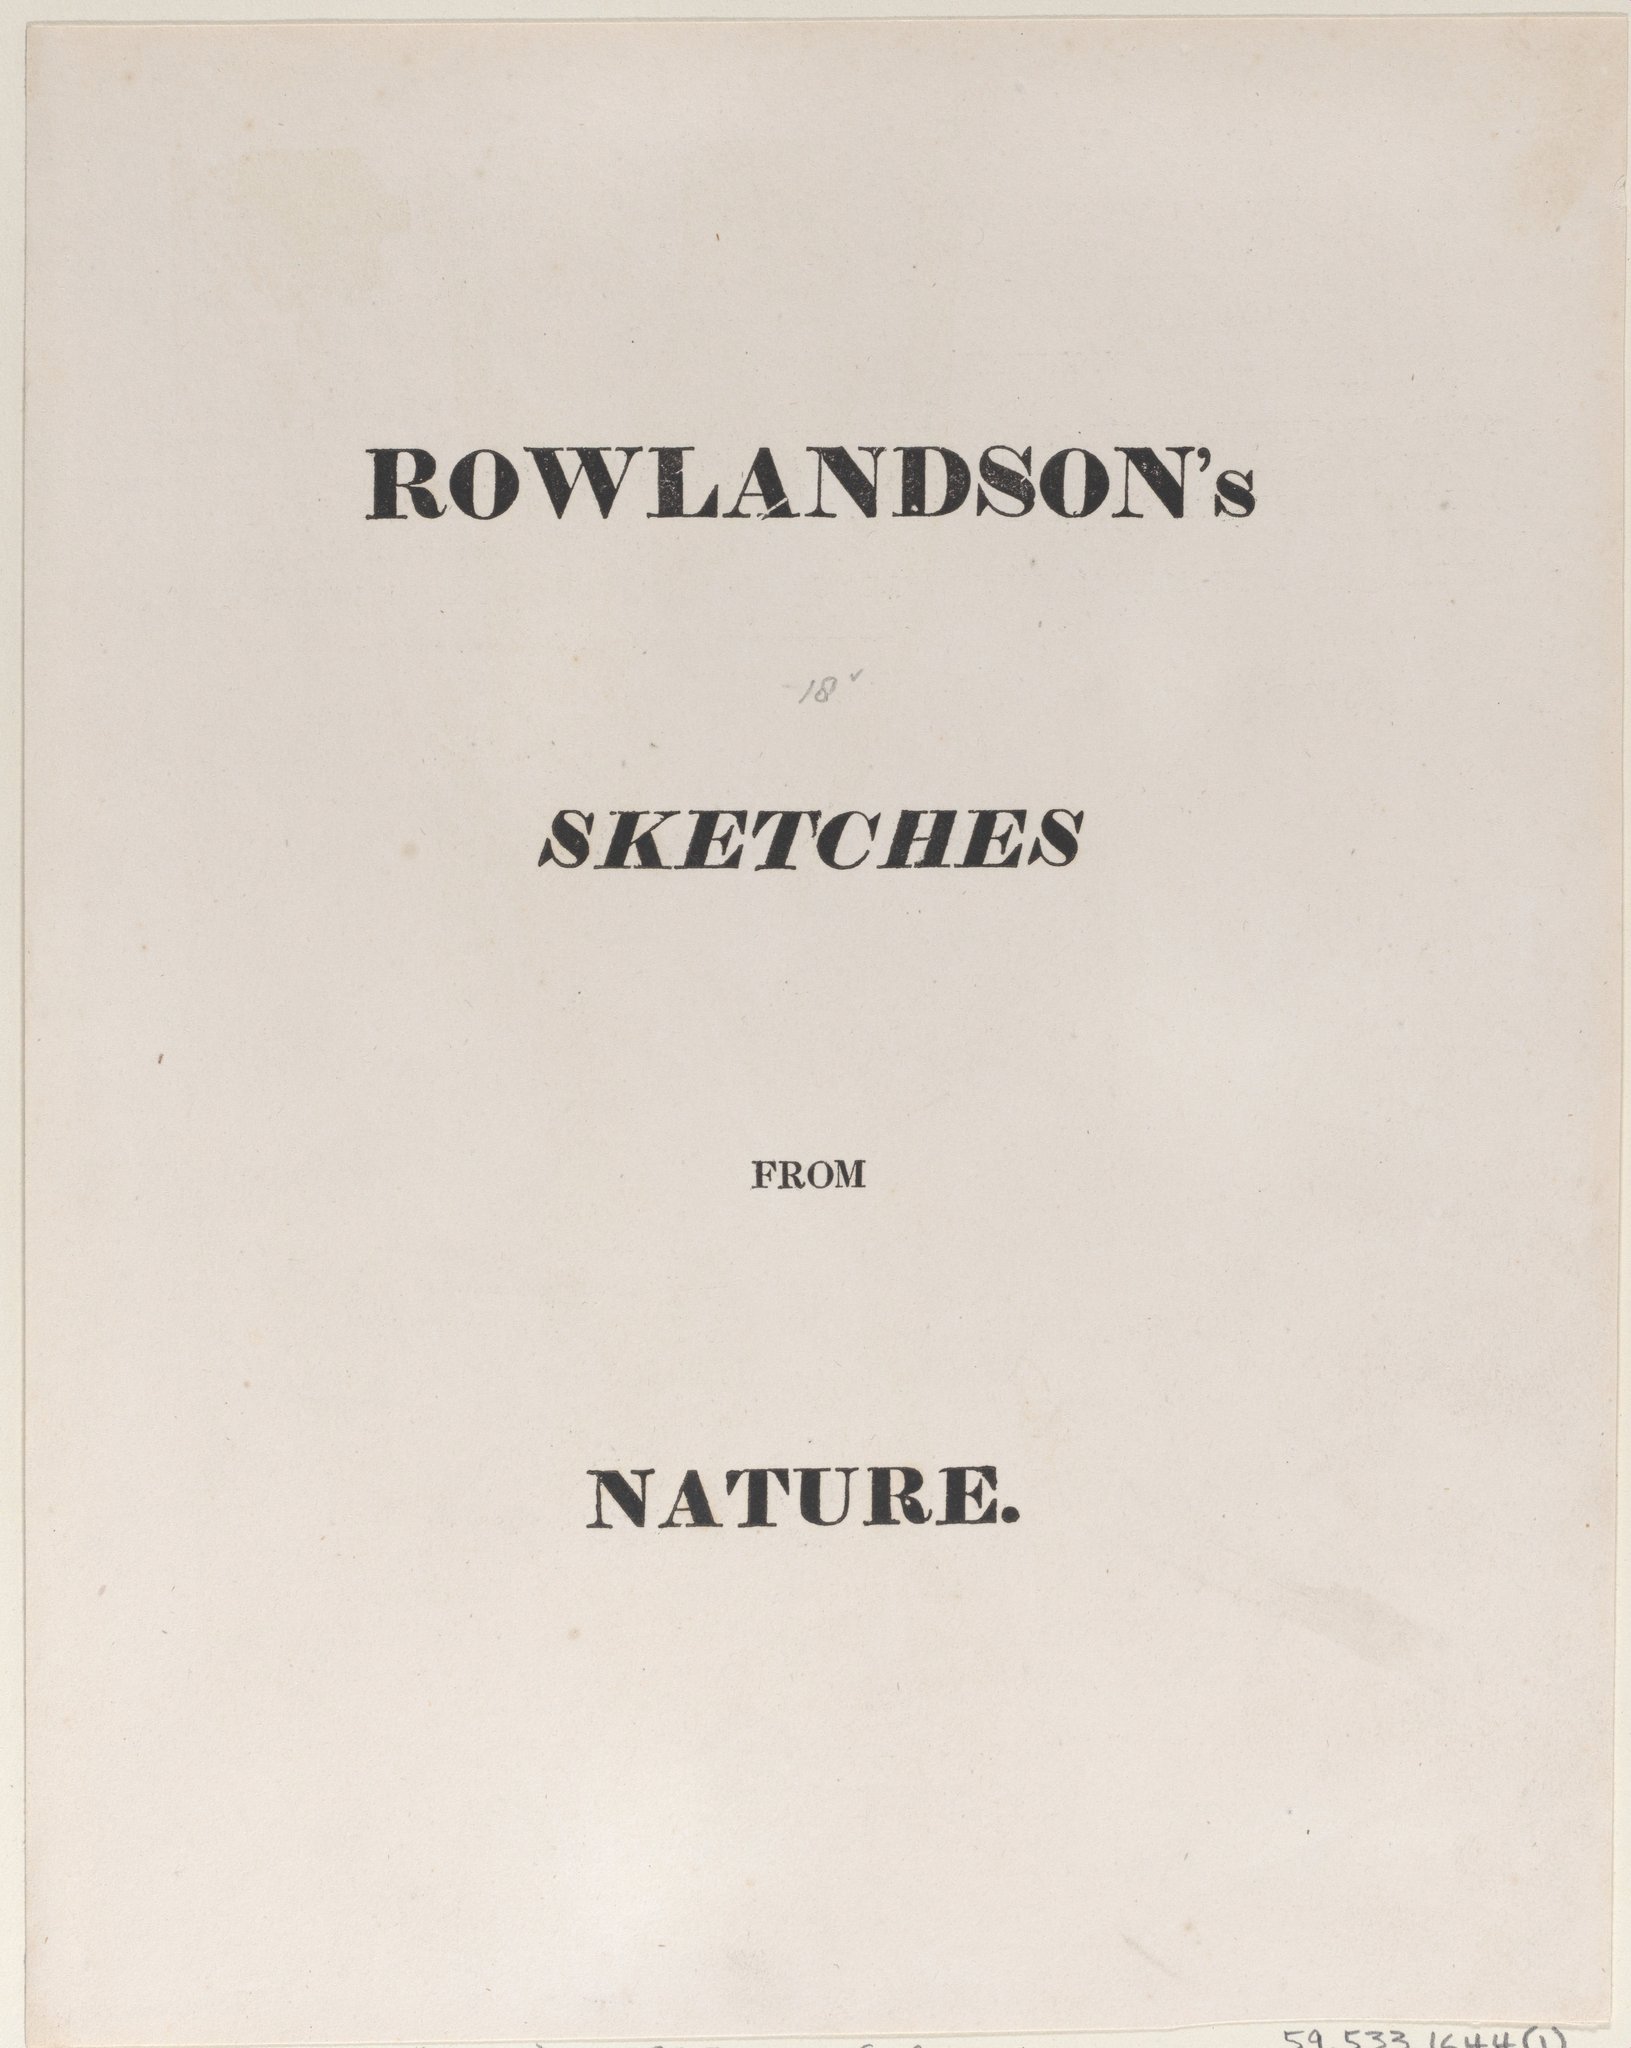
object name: print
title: Title page, from "Sketches from Nature"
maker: thomas rowlandson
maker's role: artist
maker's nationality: british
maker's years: 1757-1827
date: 1822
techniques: letterpress